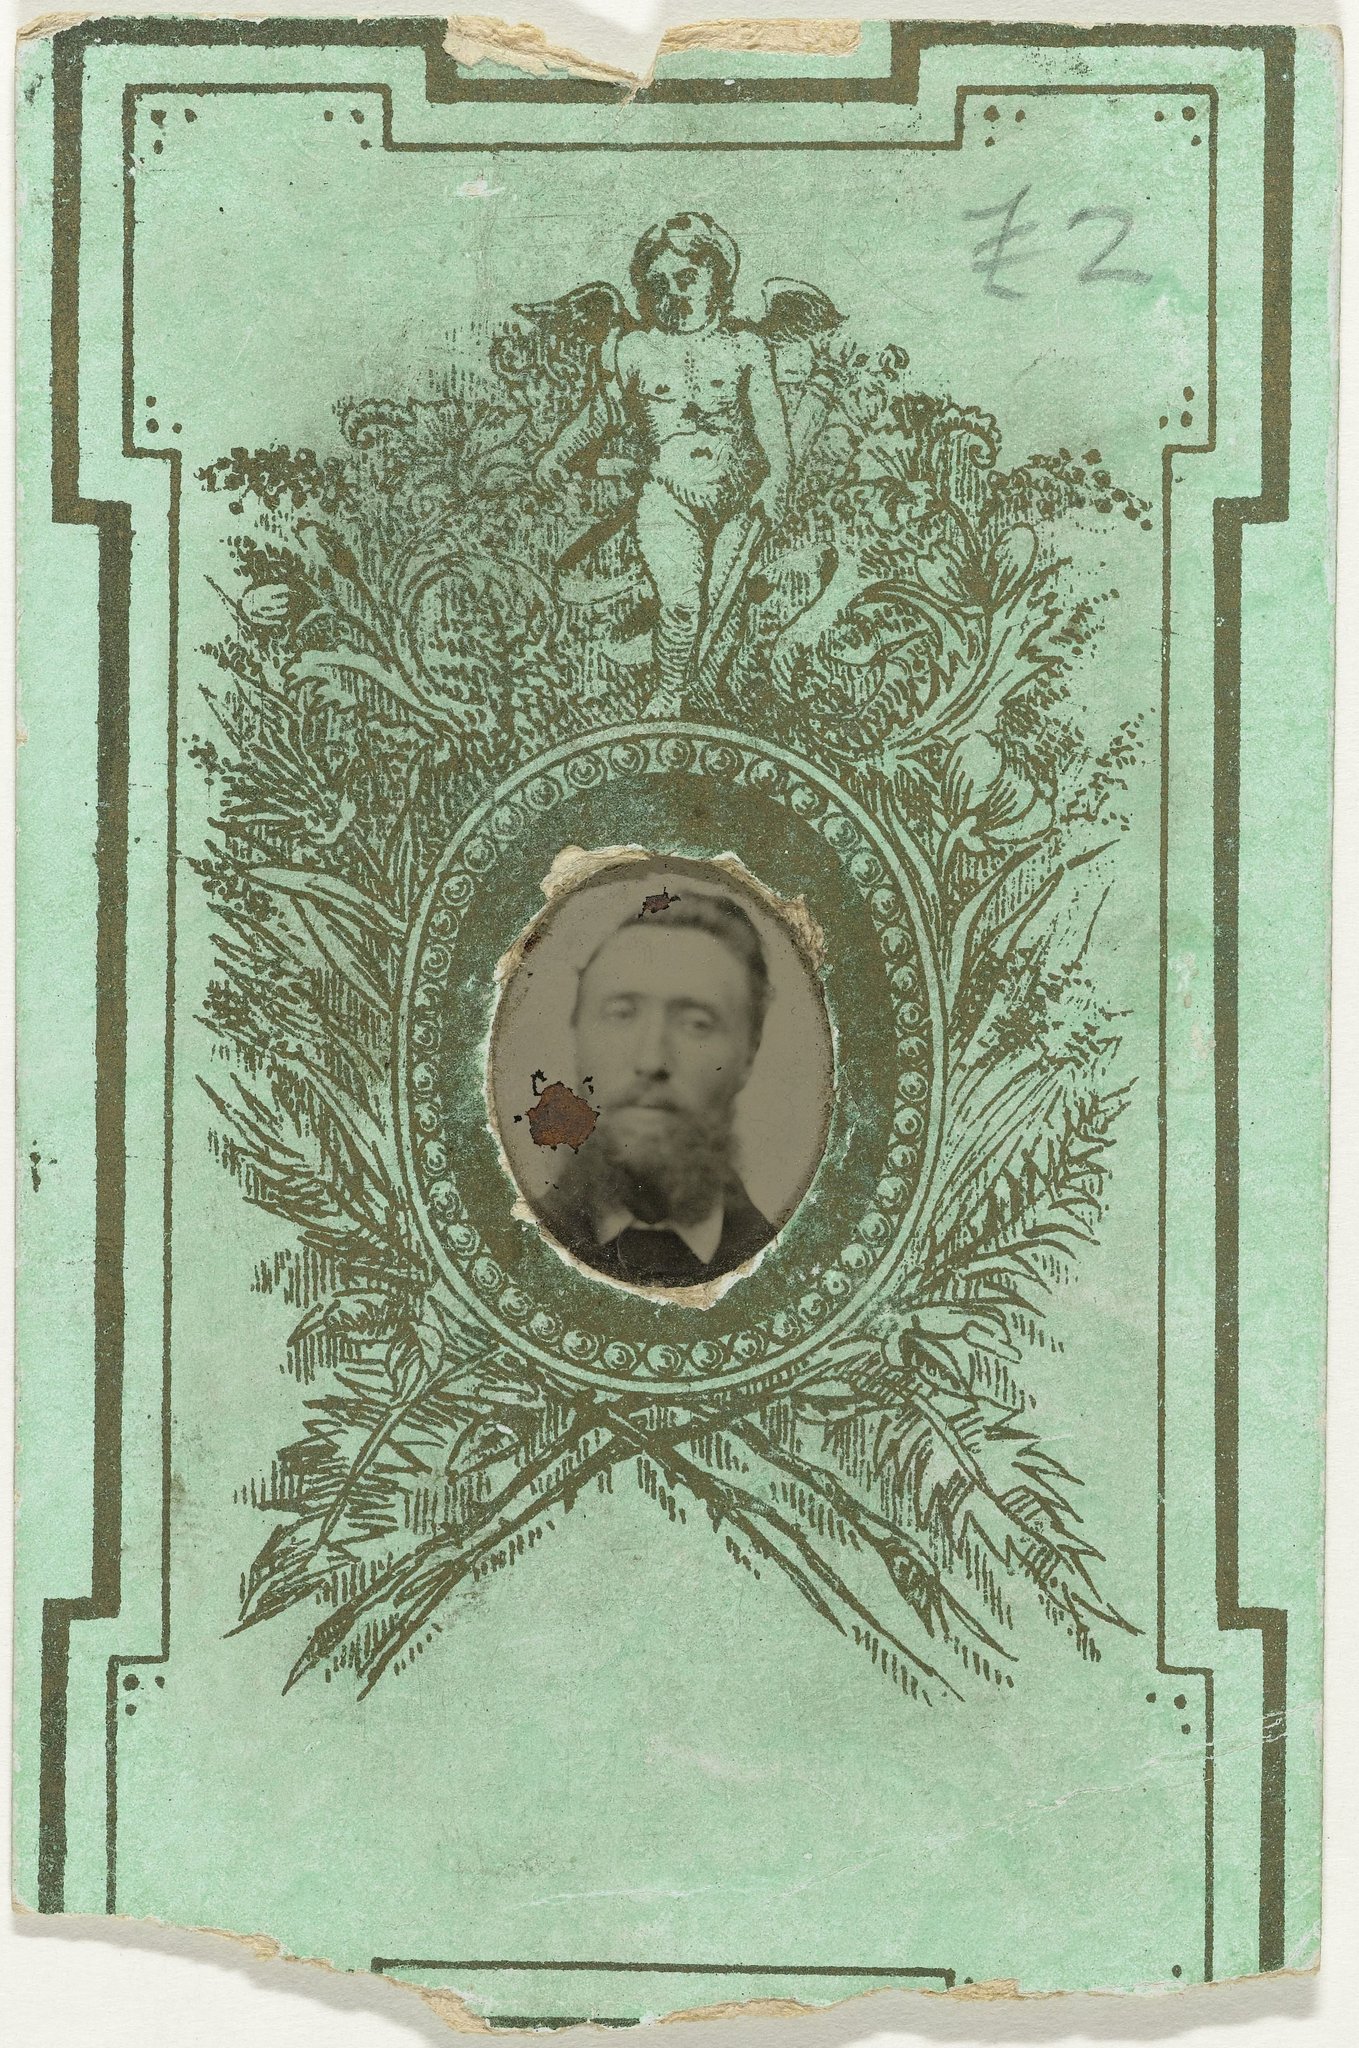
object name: photograph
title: Portret van een man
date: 1875-1900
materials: metal, paper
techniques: ferrotyping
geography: cardiff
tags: anonymous historical person portrayed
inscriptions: address: ‘3 Doz. Gem Portrtaits in 4 // positions for 2s. 6d. // 18 for 1s. 3d; 9 for 7½ d. // OR LIKE THIS, 1s. // 9 Victorias, 2/6, mounted in // Cards, // Taken and Finished in a // few minutes, by the // AMERICAN GEM // VICTORIA AND // FERROTYPE CO., // 15, Crockherbtown, Cardiff. // 123, Southgate St., Glo’ster // And 9, Castle St., Swansea.’’